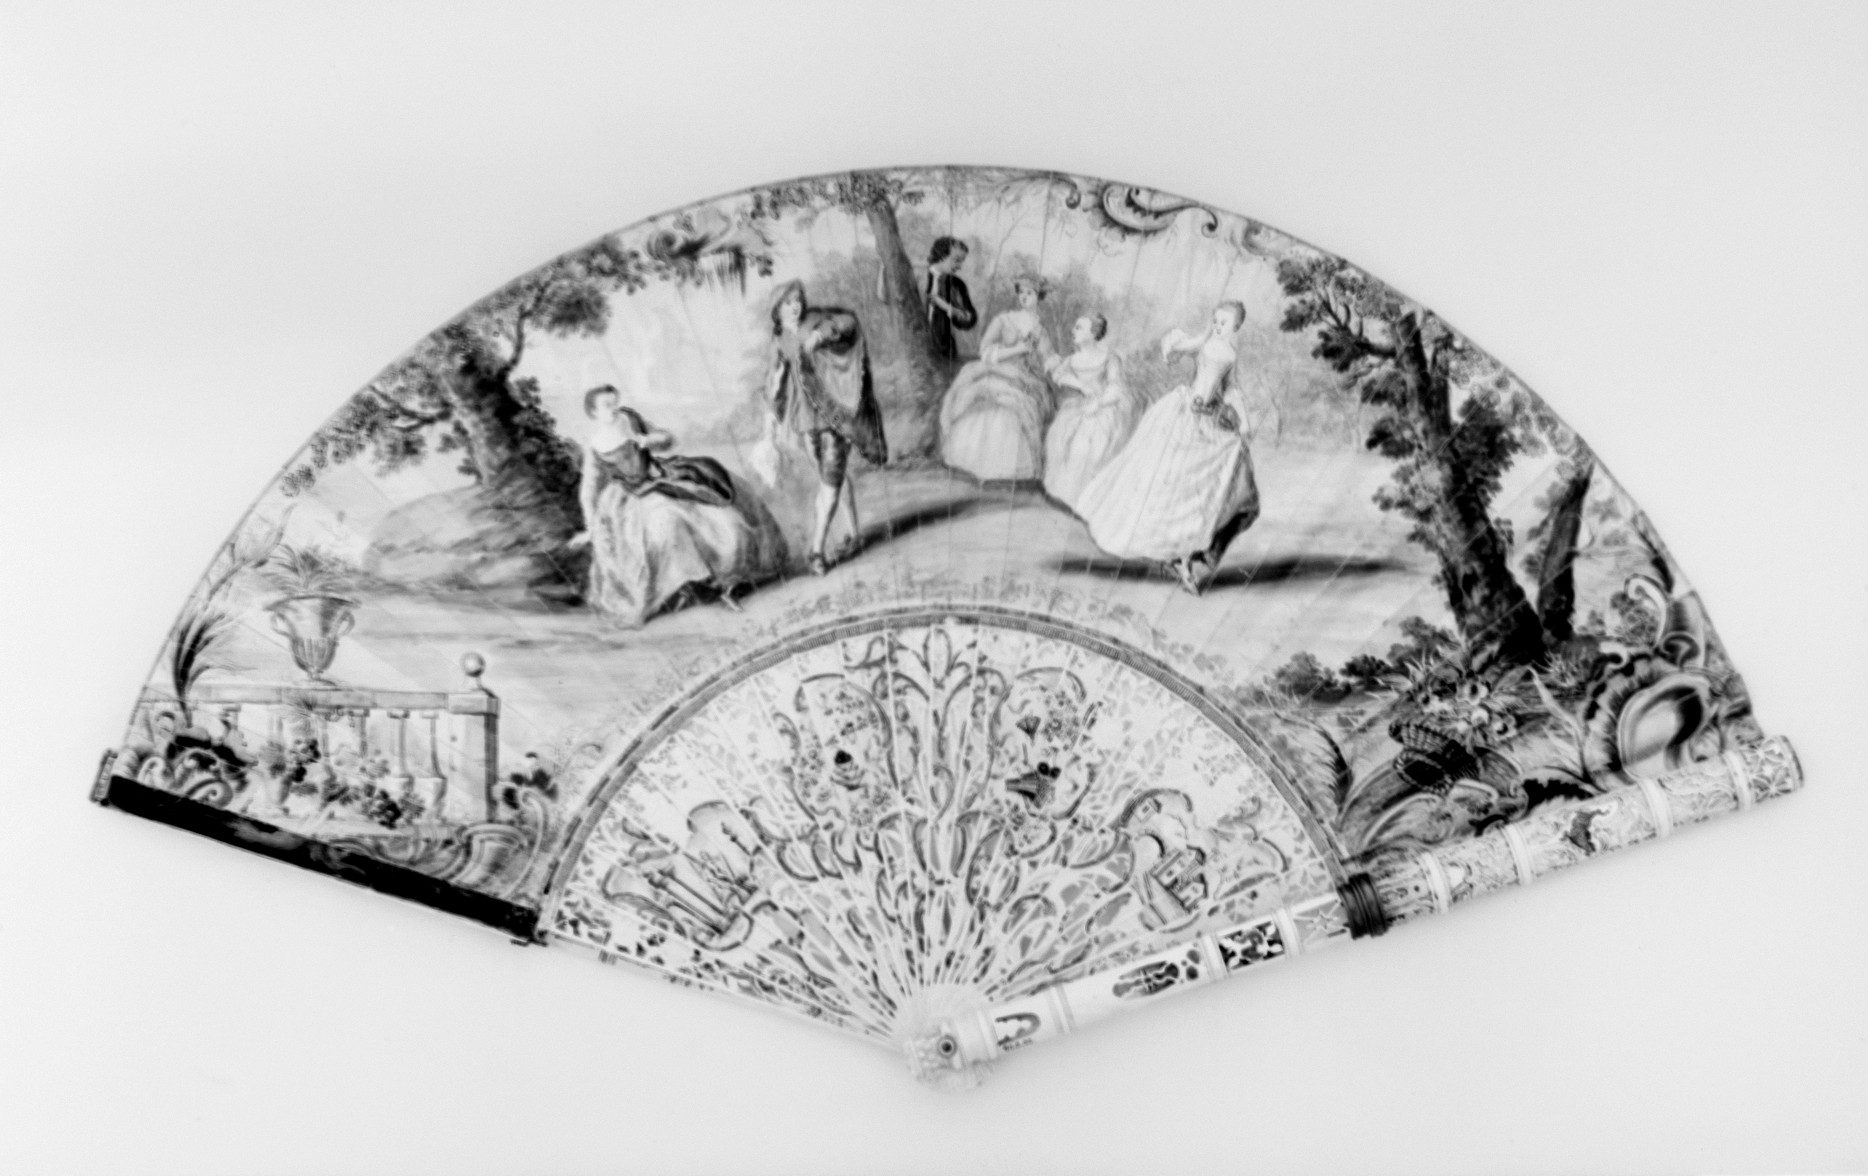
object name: fan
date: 1730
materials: ivory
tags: men,women